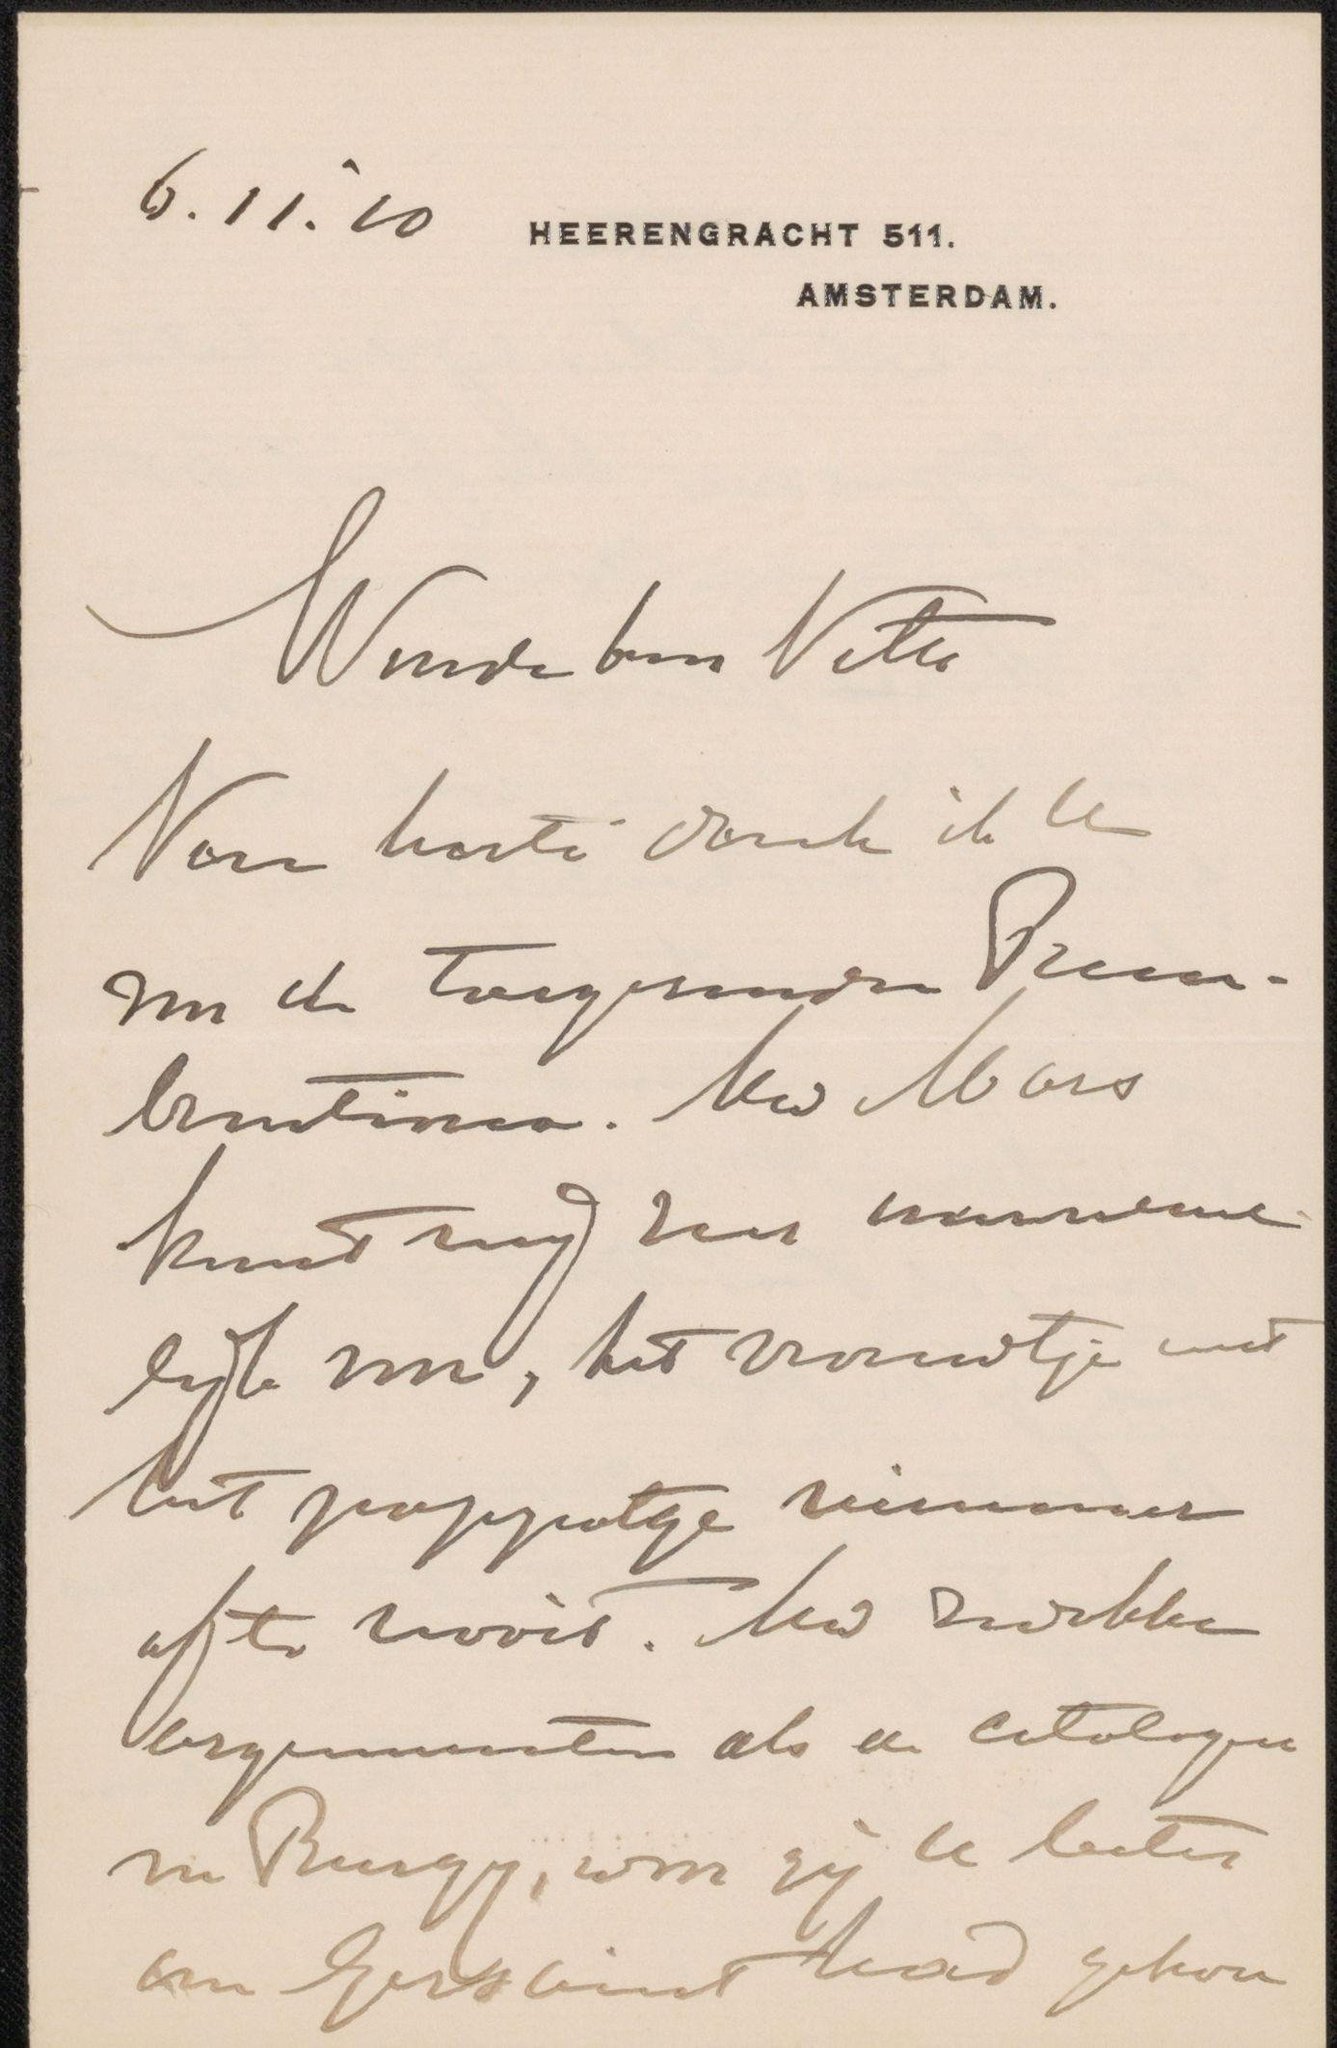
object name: letter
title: Brief aan Jan Veth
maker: jonkheer jan six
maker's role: hoogleraar, kunsthistoricus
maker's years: 1857-1926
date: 1910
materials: ink, paper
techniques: pen, printing, writing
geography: amsterdam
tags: dordrecht, designer, jan veth, leiden, amsterdam, painter, print maker, draughtsman, rembrandt van rijn, the graphic arts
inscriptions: collector's mark: ‘RPK’, watermark